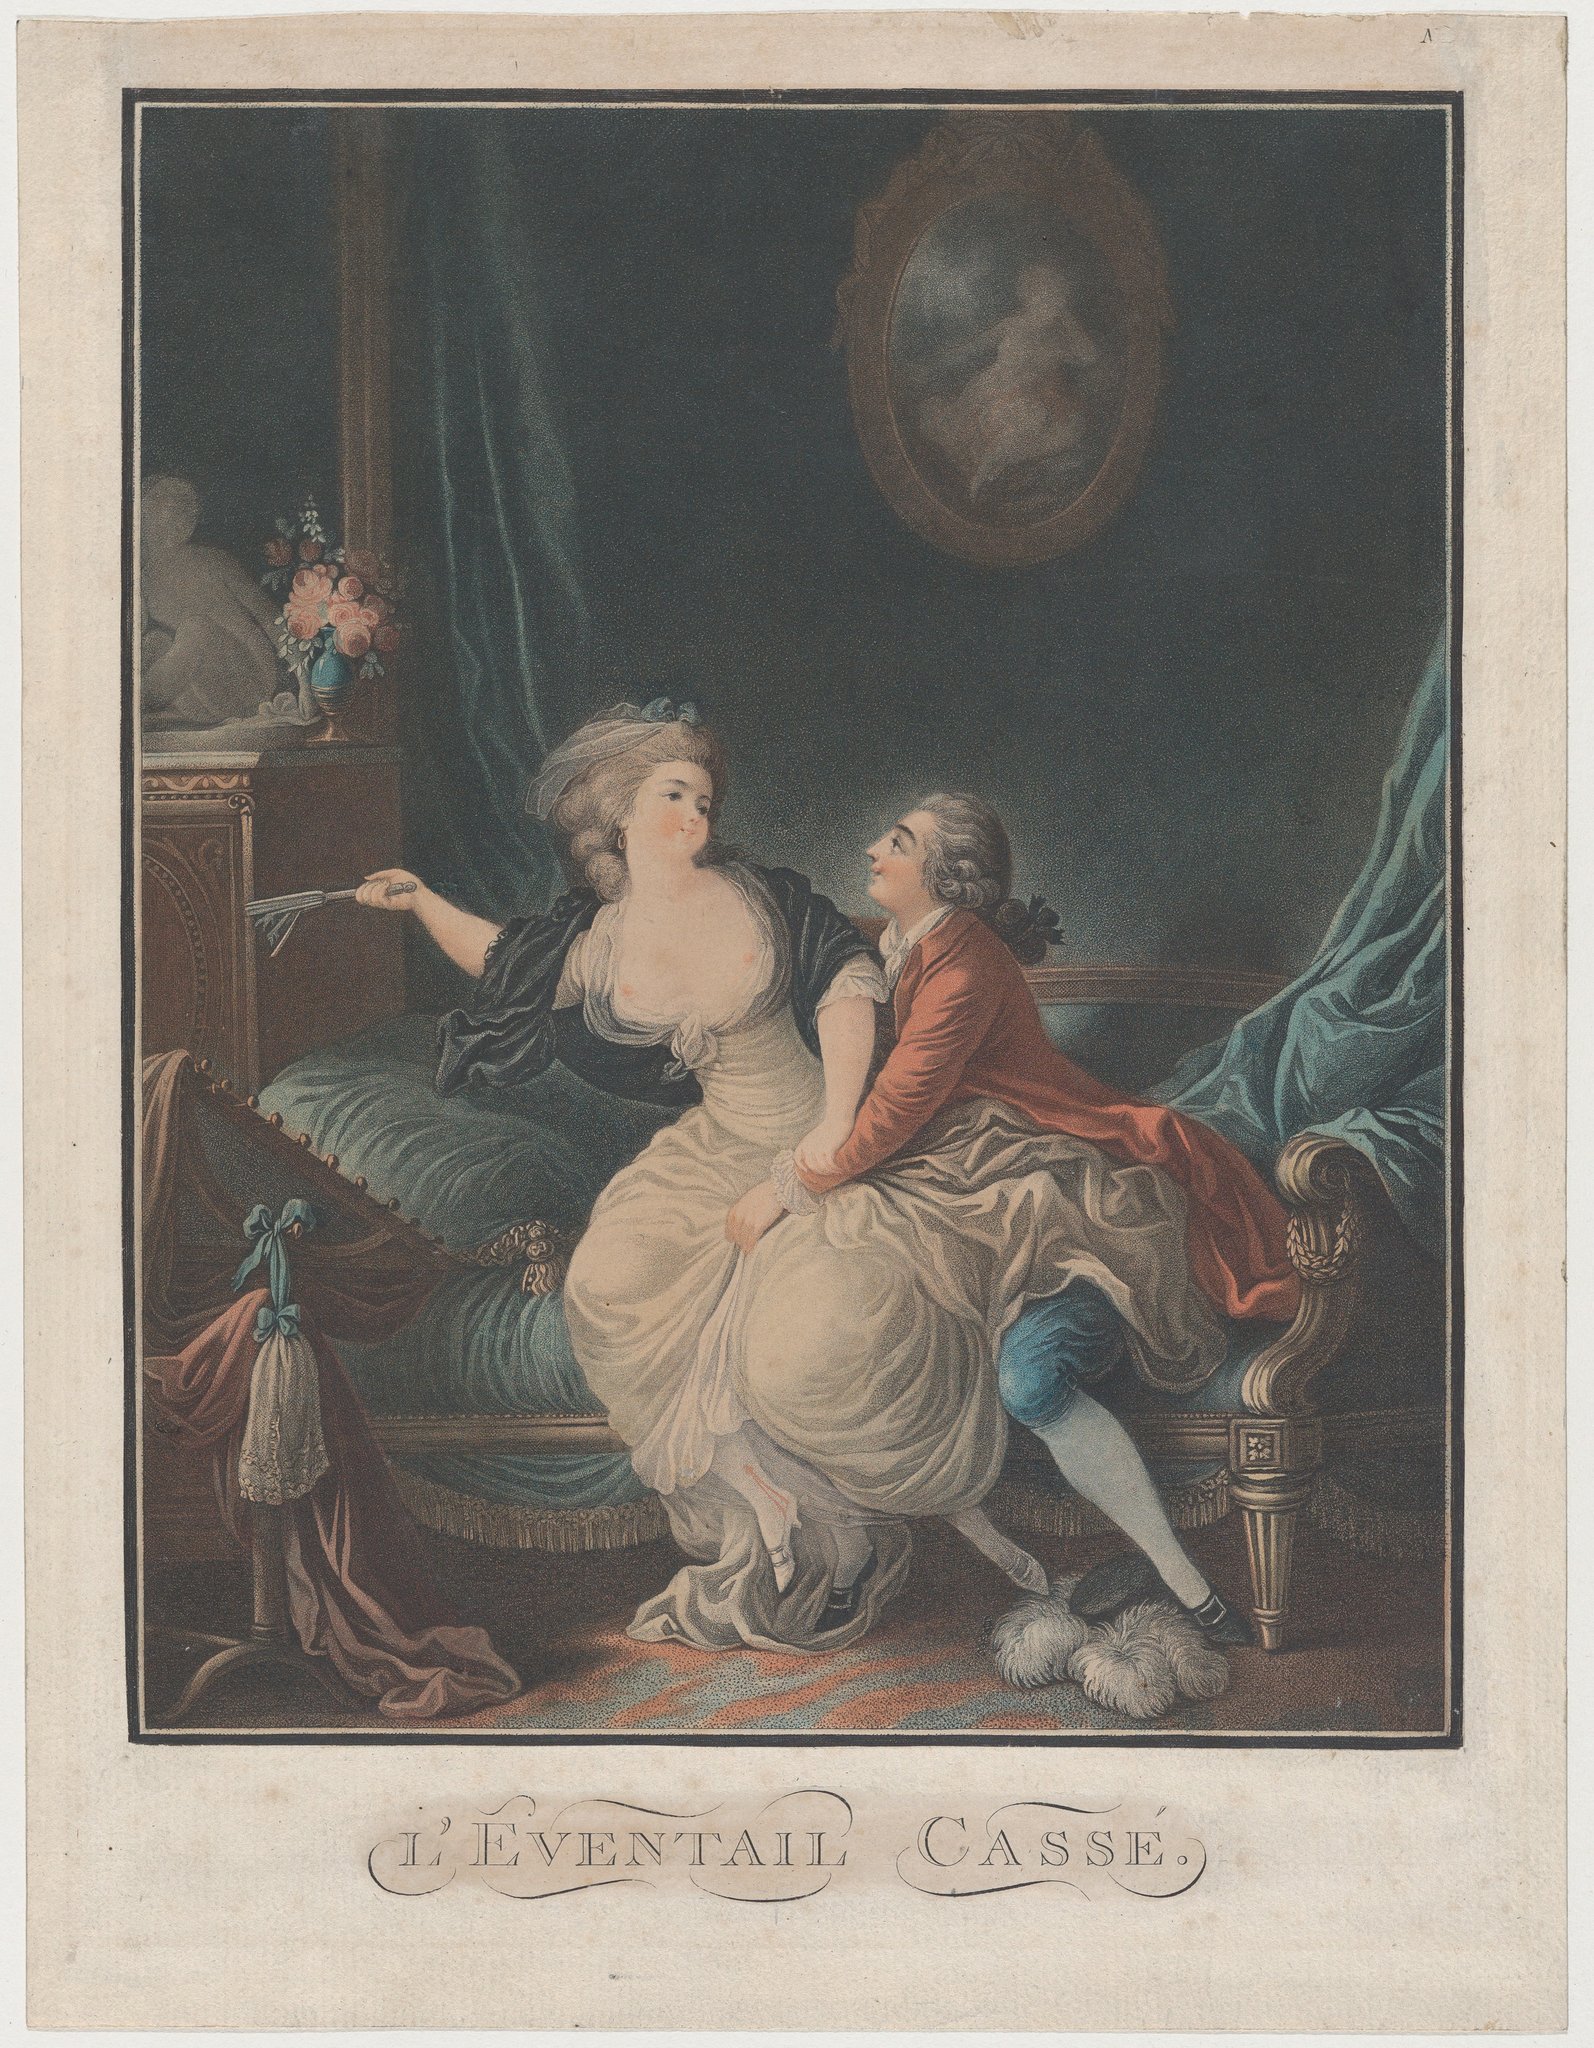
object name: print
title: The Broken Fan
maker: louis marin bonnet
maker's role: artist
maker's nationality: french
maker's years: 1736-1793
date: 1787-1793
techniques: stippling, wash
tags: men,portraits,women